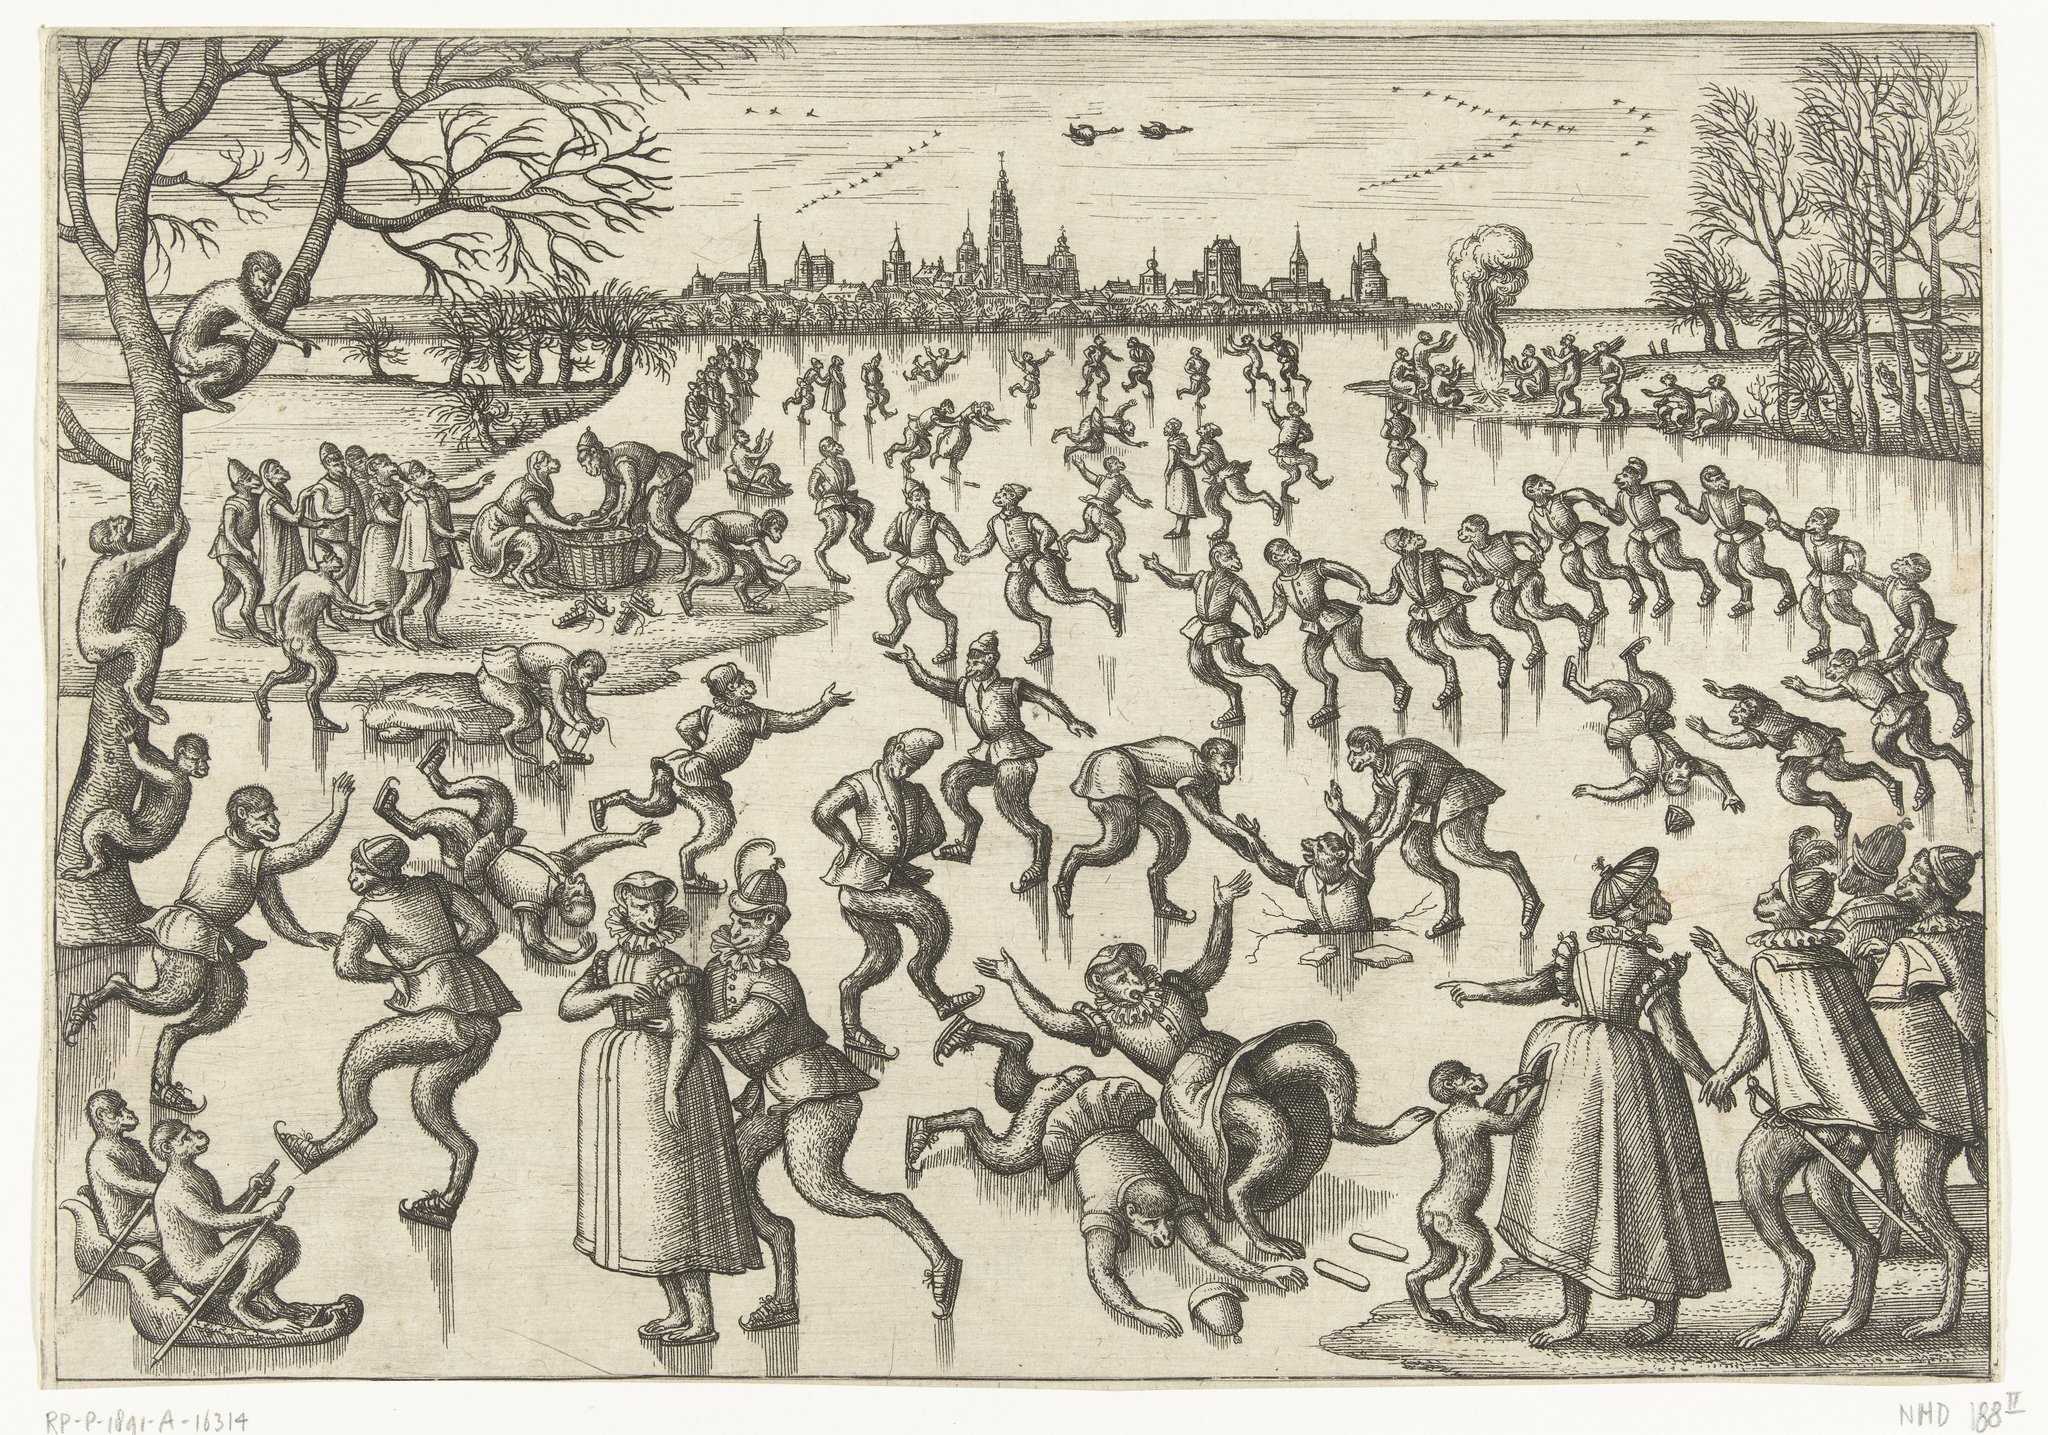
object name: print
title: Apenspel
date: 1545-1608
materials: paper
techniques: etching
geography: antwerp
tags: monkeys, apes, 'mundus inversus', the reversed world, the topsy-turvy world, 'le monde bestourné', skates (winter sports)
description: Schaatsende apen op de Schelde, net buiten Antwerpen. Apen schaatsen samen of alleen over het ijs. Er zijn valpartijen en een van de apen is zelfs door het ijs gezakt. Toeschouwers kijken naar het schouwspel. Op de achtergrond de stad Antwerpen.